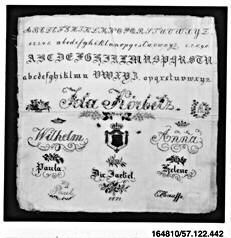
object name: sampler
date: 1871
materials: cotton, linen, metal thread, silk